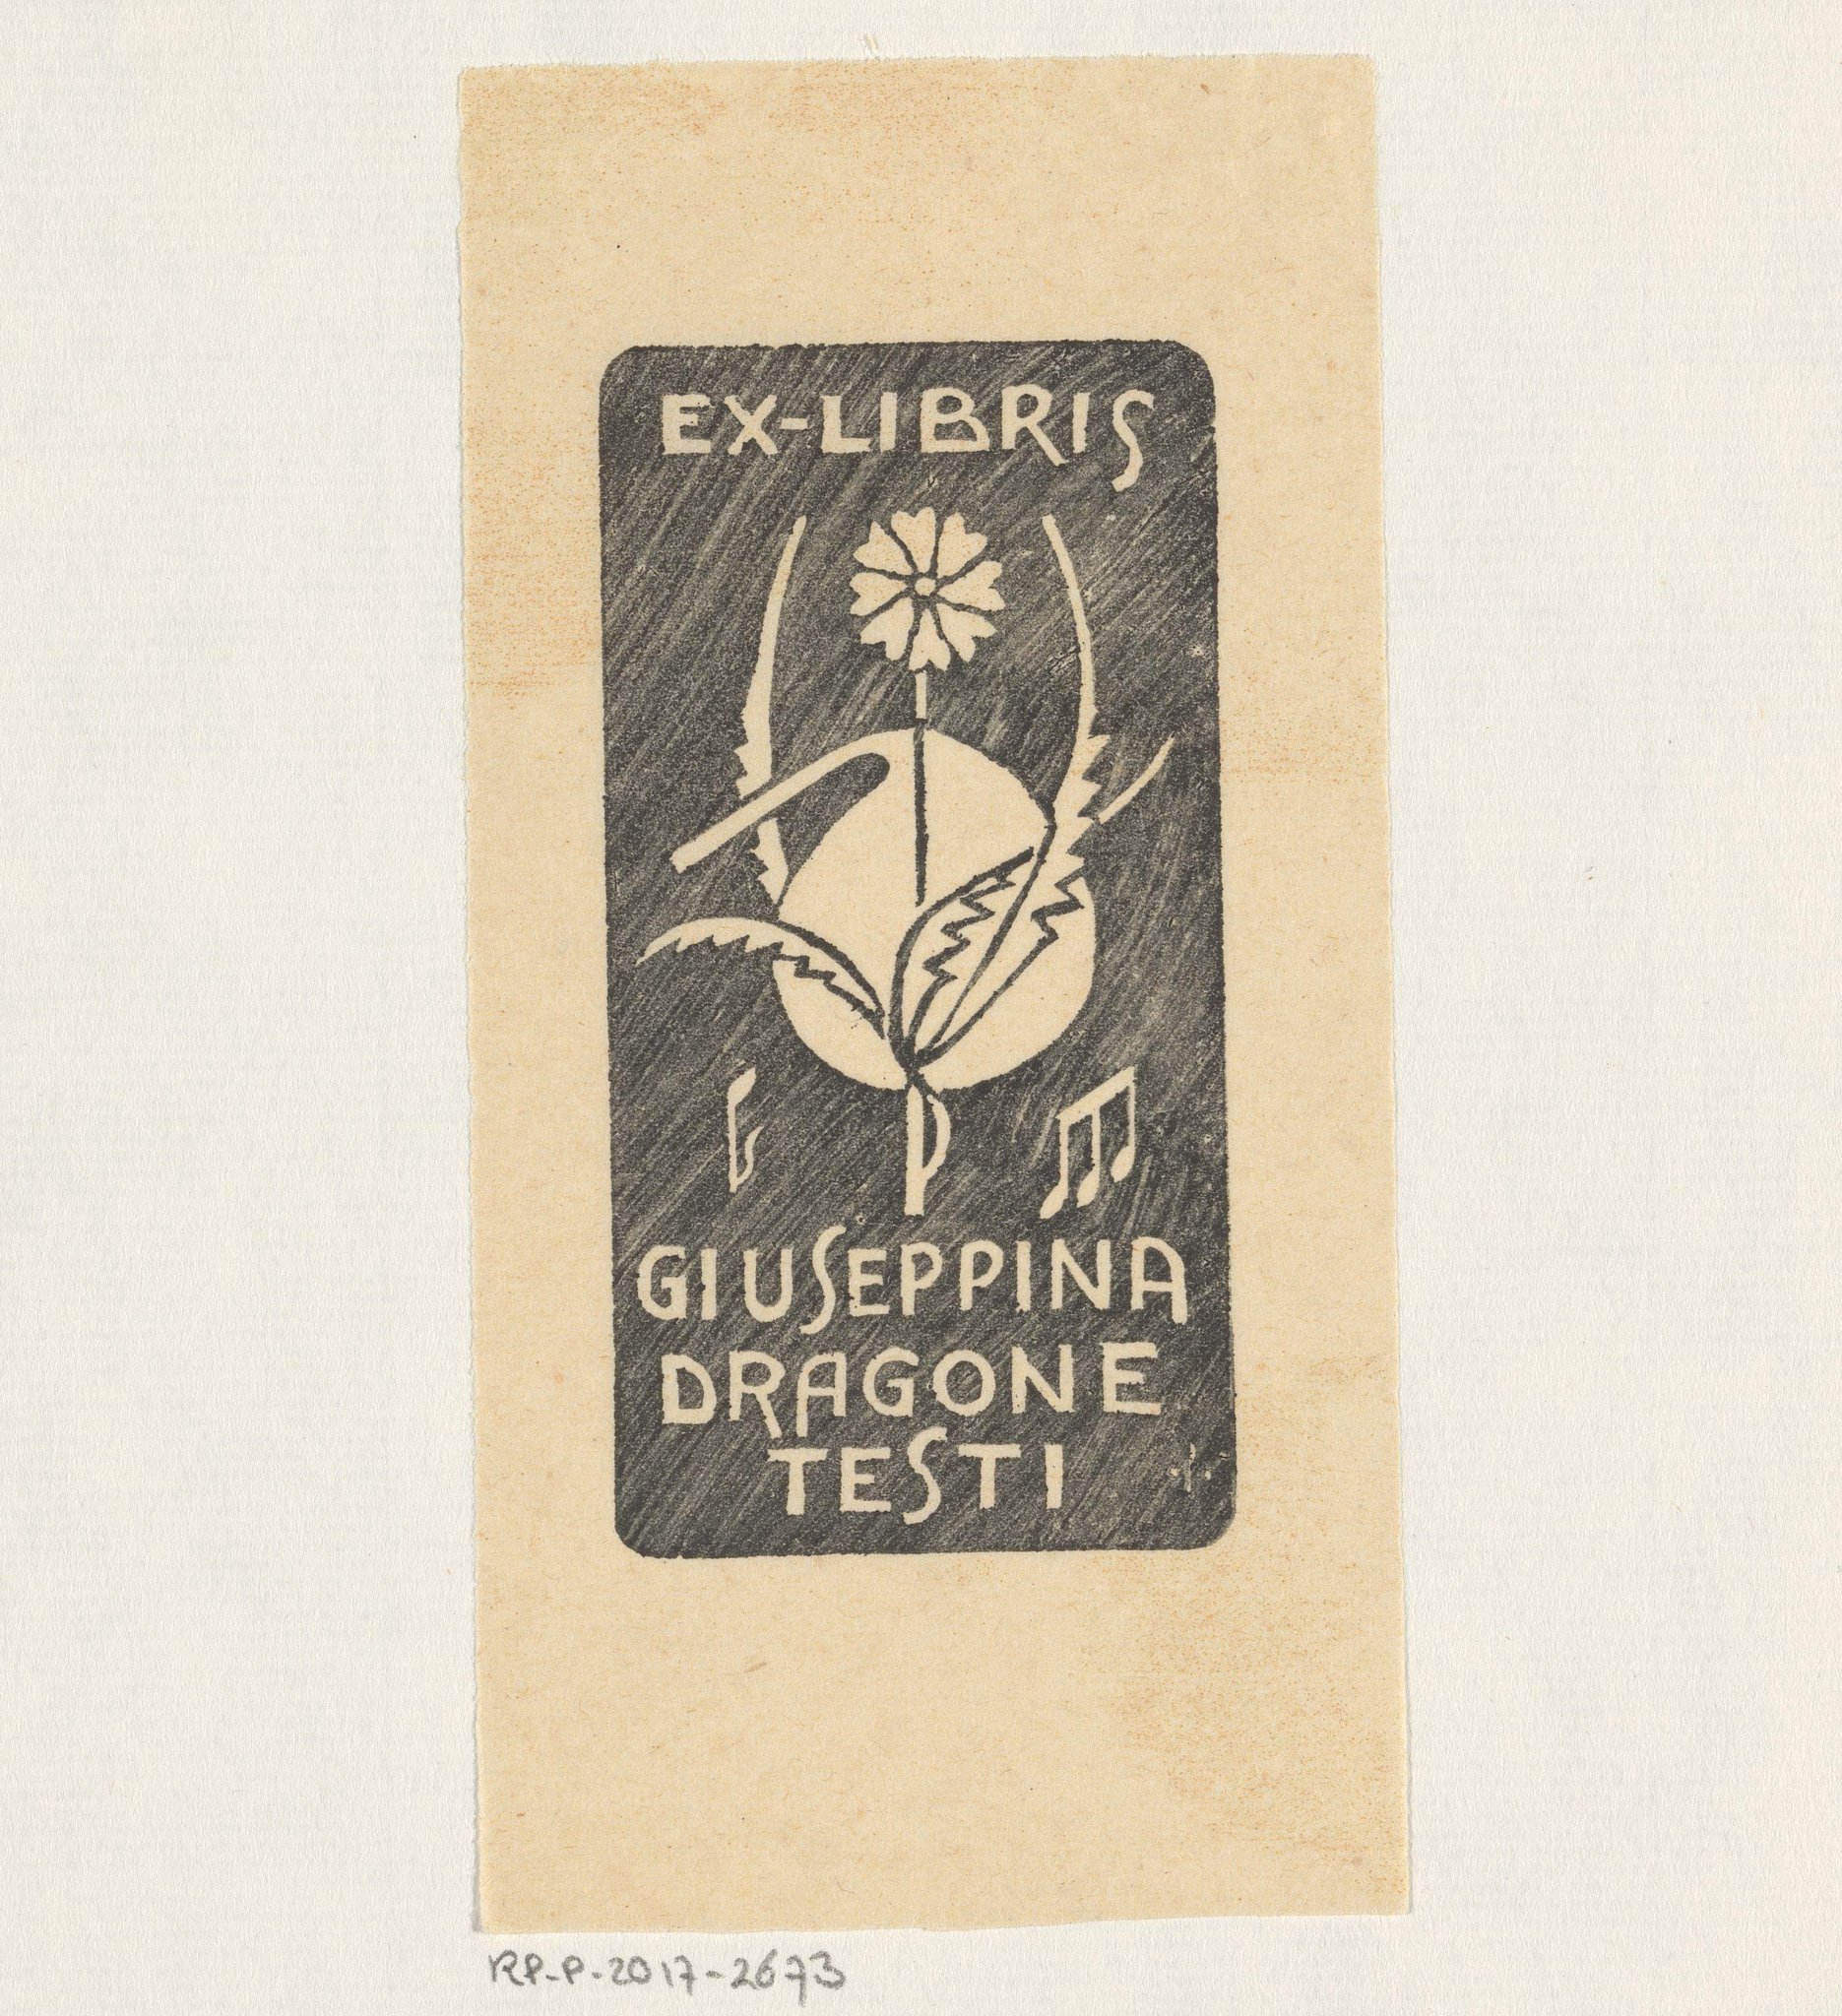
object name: bookplate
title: Ex libris van Giuseppina Dragone Testi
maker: Anonymous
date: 1900-1999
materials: paper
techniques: lithograph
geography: italy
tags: flowers, notation of music, additional stages: distillation (destillatio)